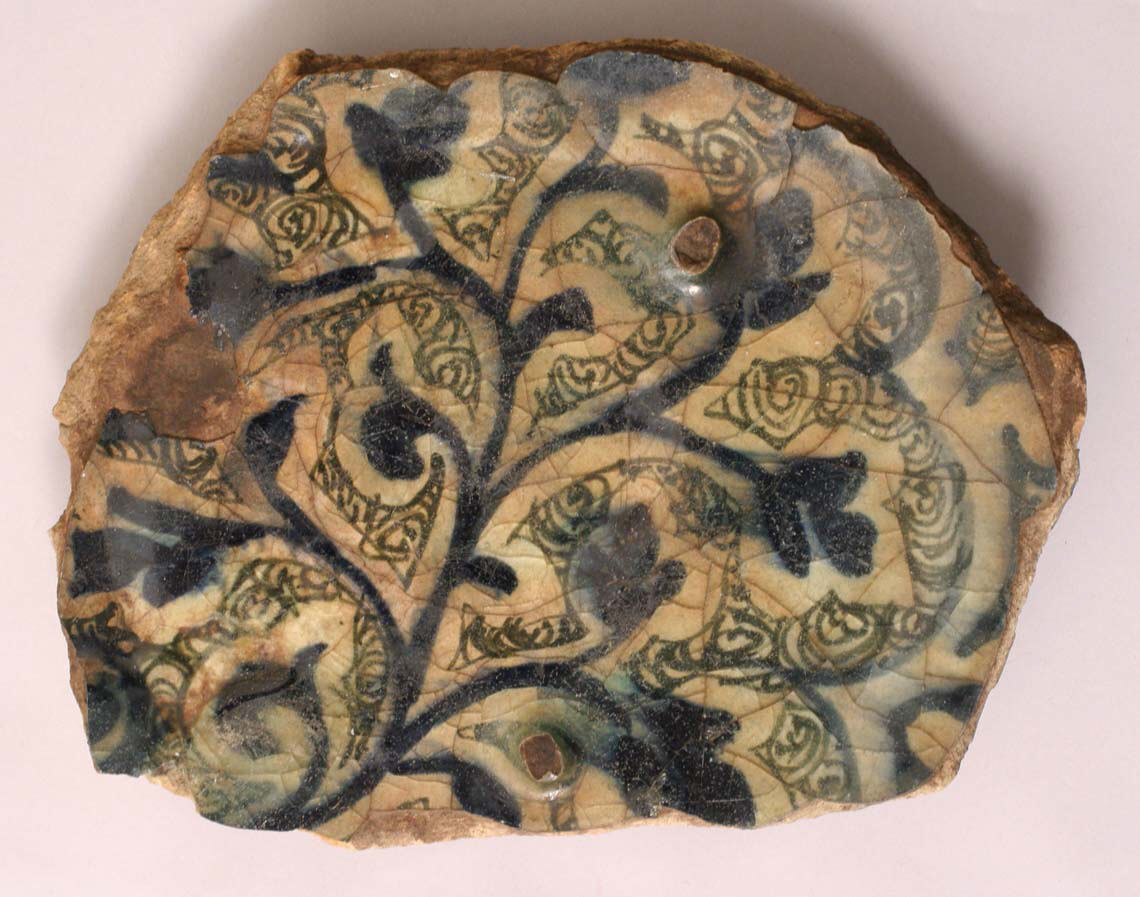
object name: fragment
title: Ceramic Fragment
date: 1301-1400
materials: glaze, stonepaste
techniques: painting, polychrome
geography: syria